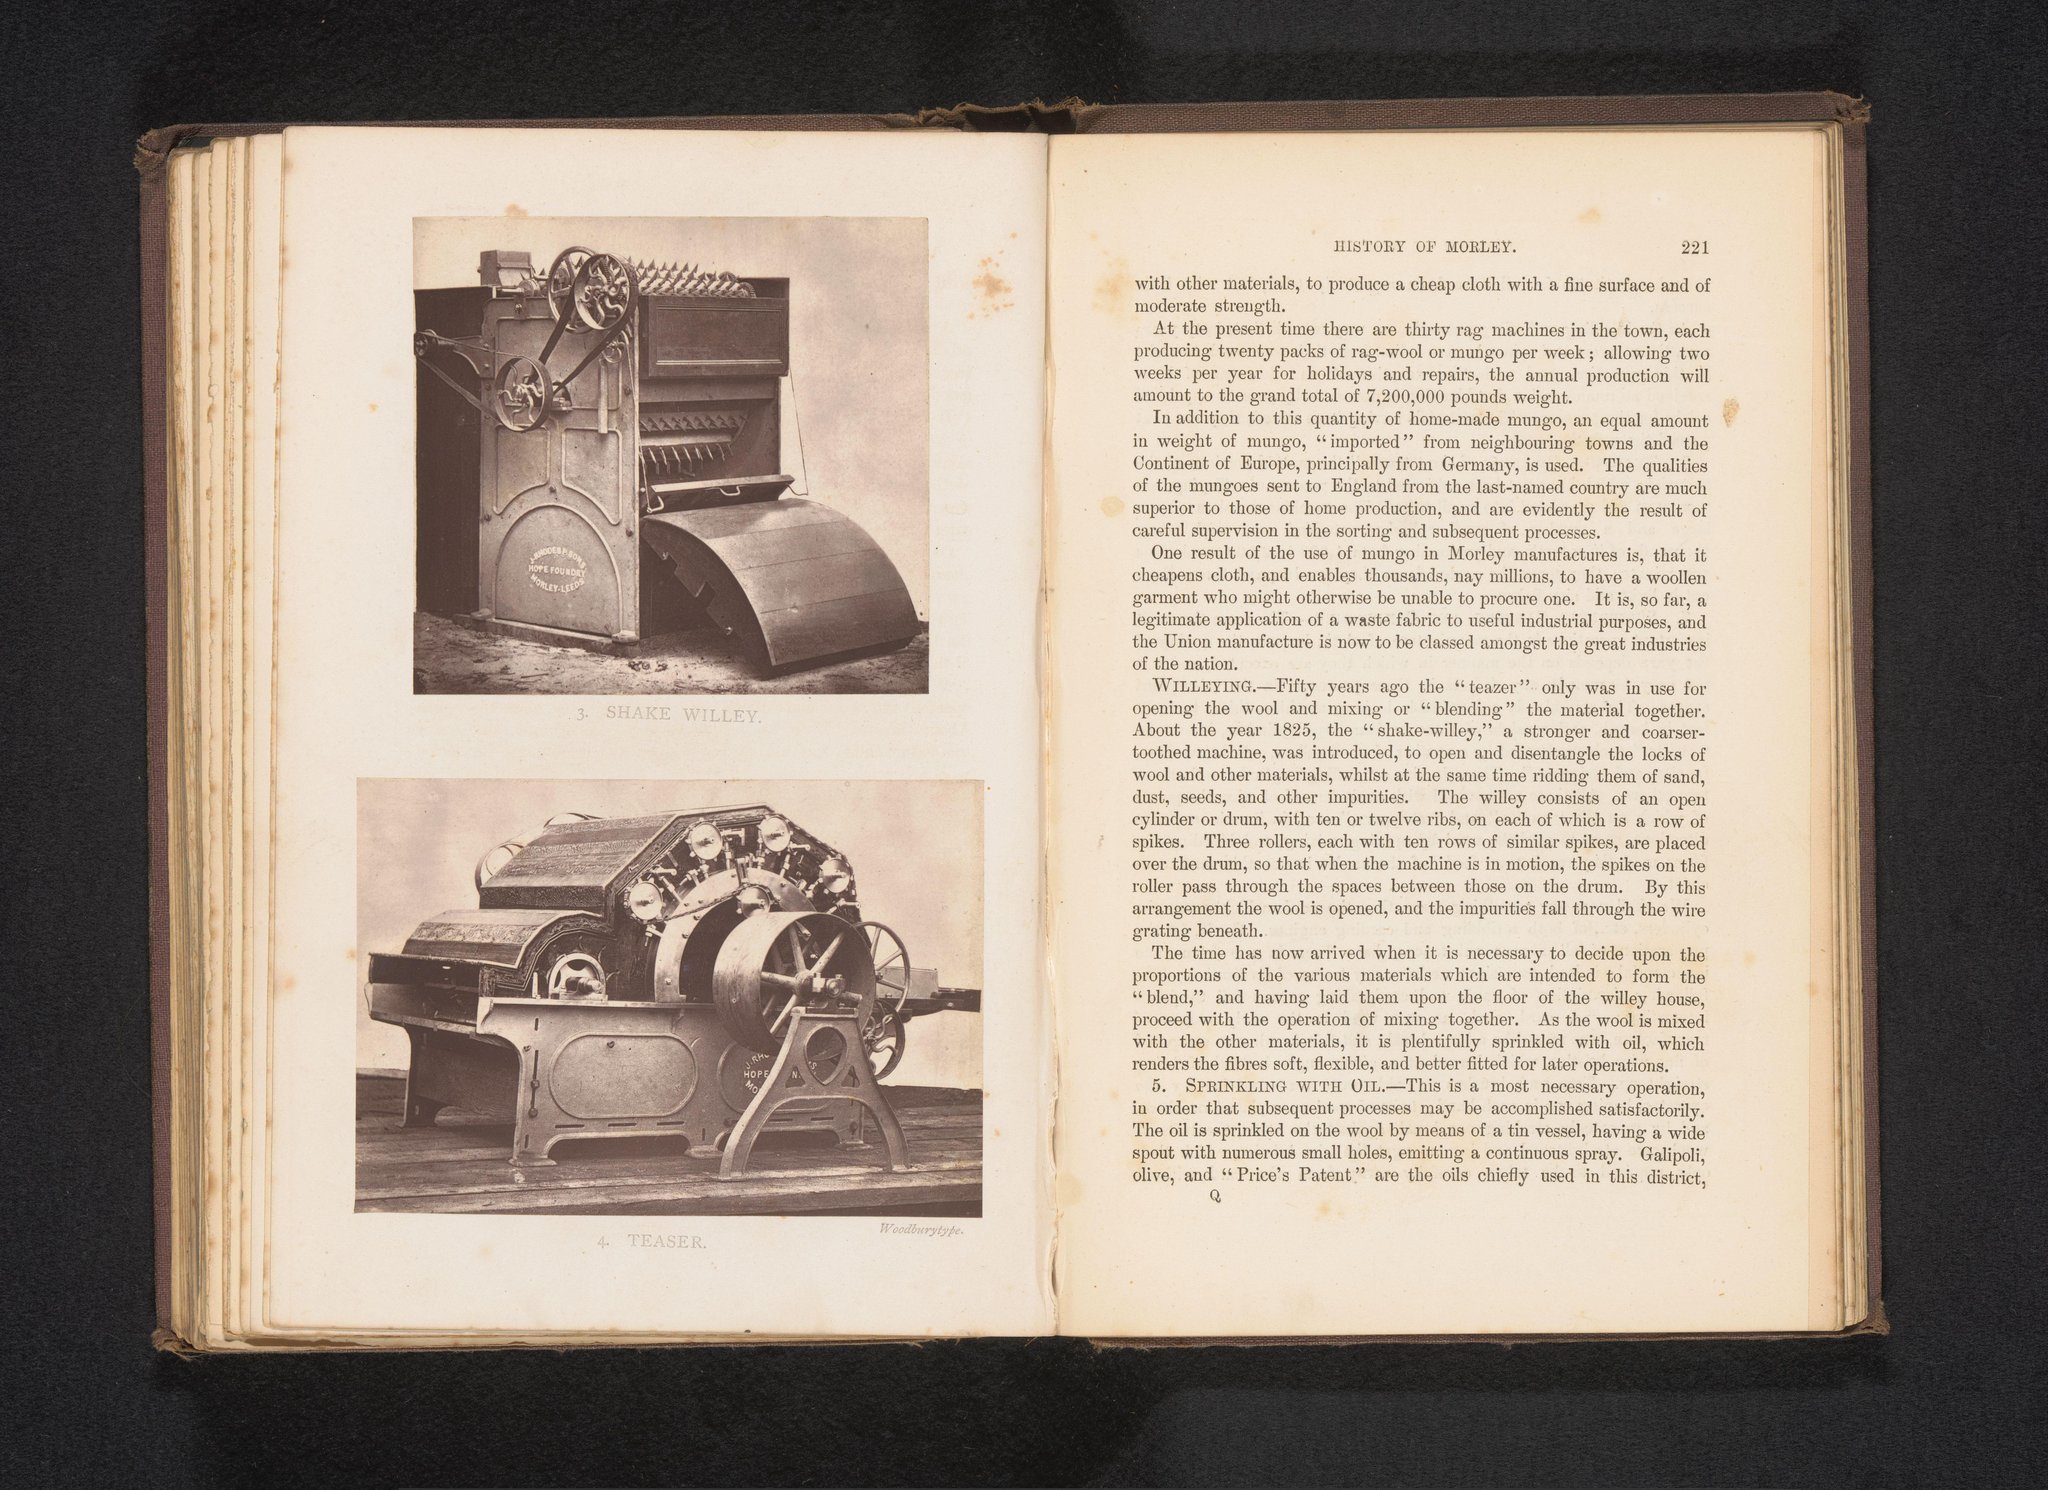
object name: photomechanical print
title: Gezicht op een machine om wol te behandelen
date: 1871-1876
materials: paper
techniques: woodburytype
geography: bradford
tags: machine driven by human or animal power